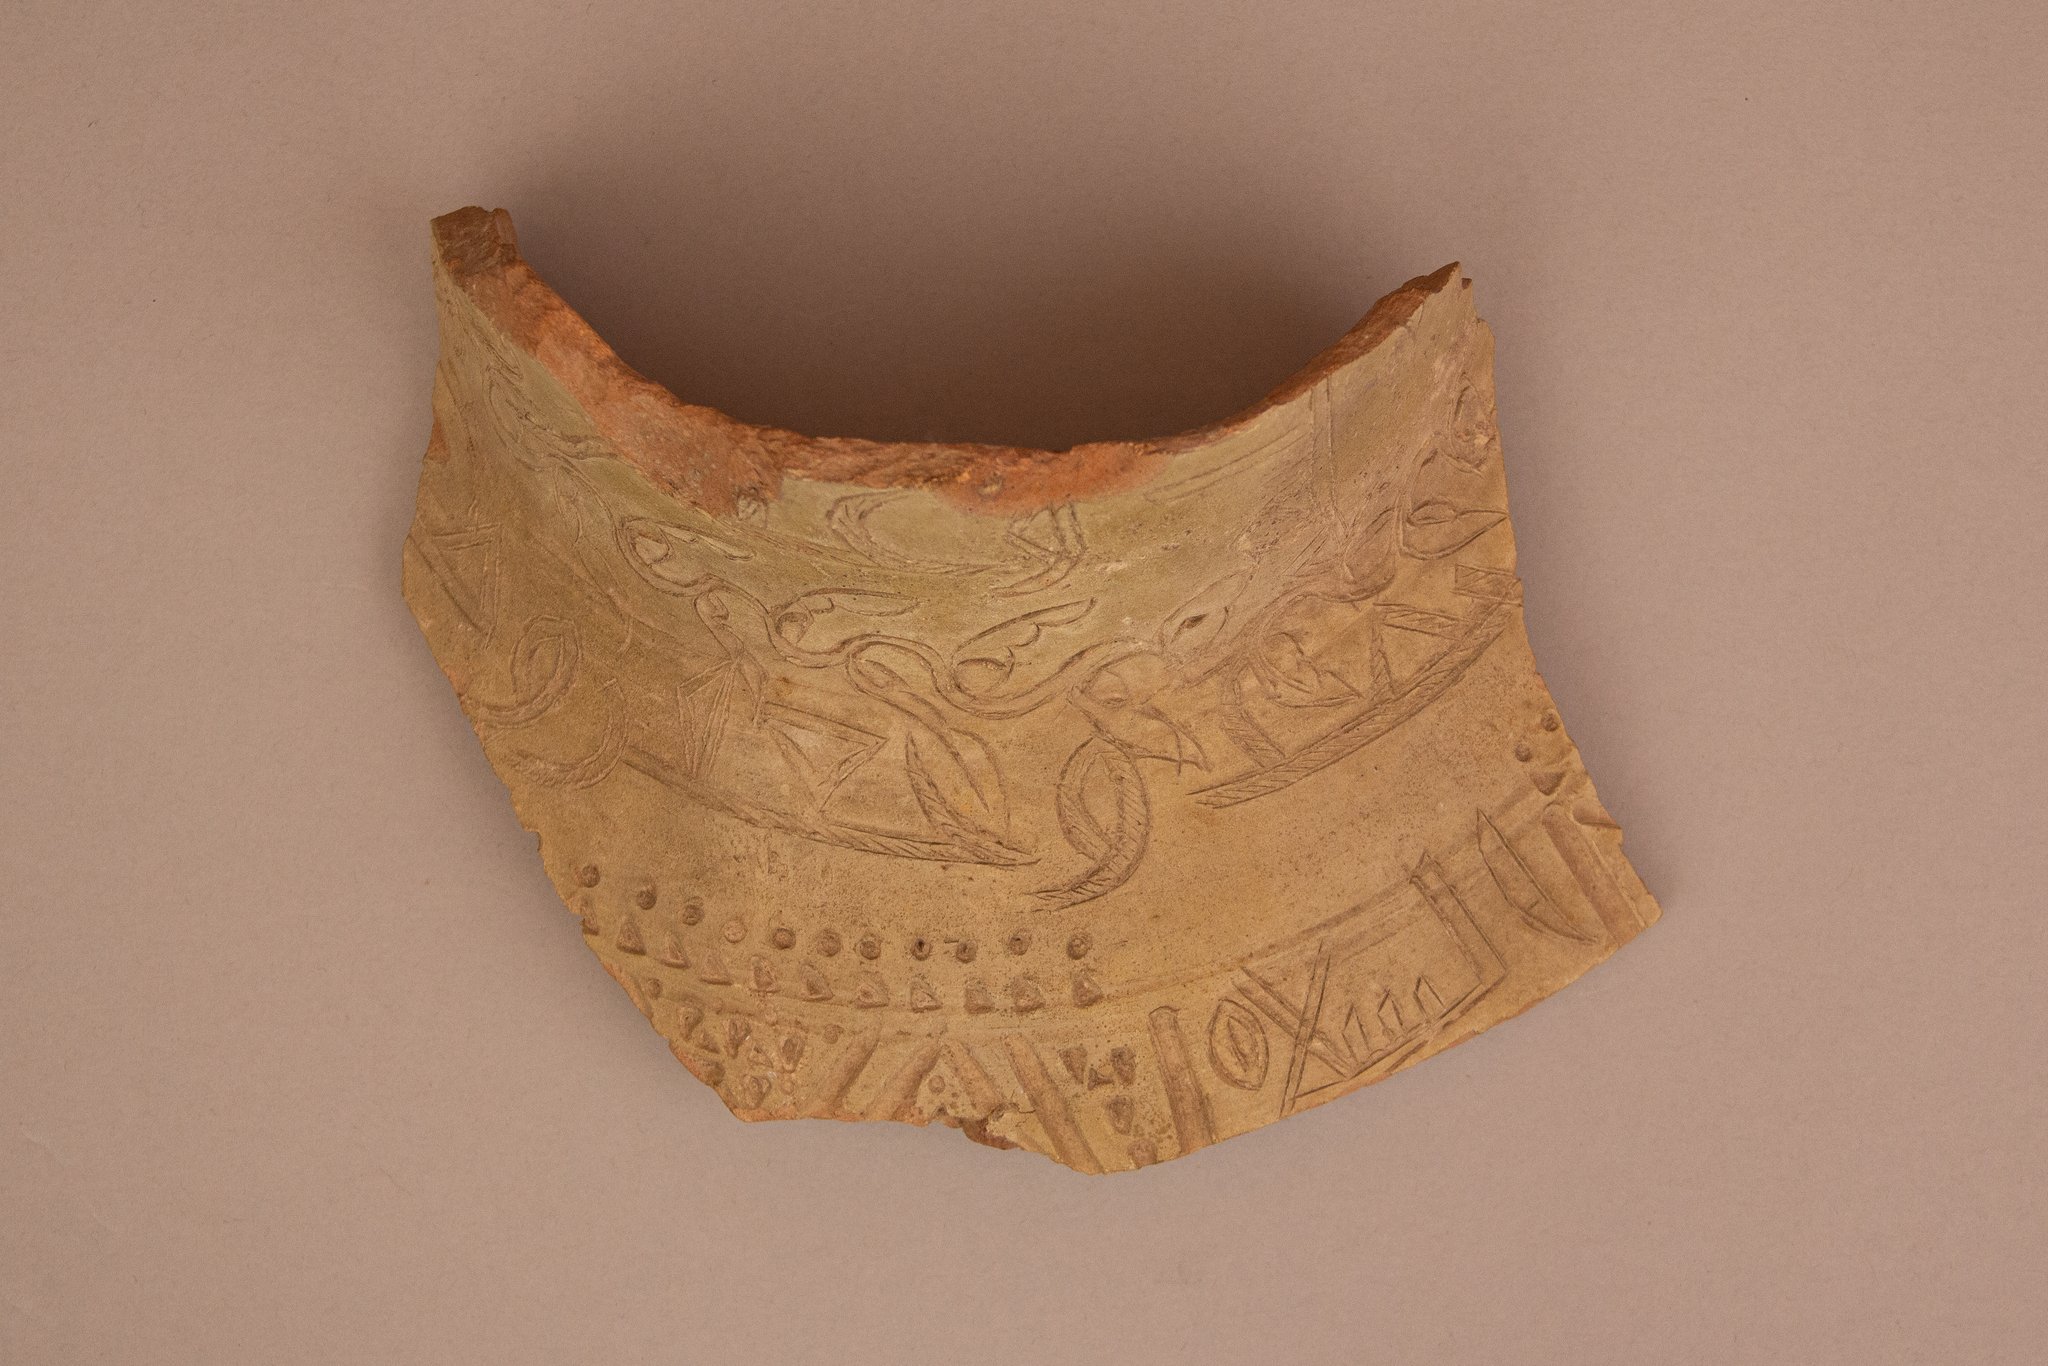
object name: fragment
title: Ceramic Fragment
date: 801-900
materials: earthenware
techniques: incising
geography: iran